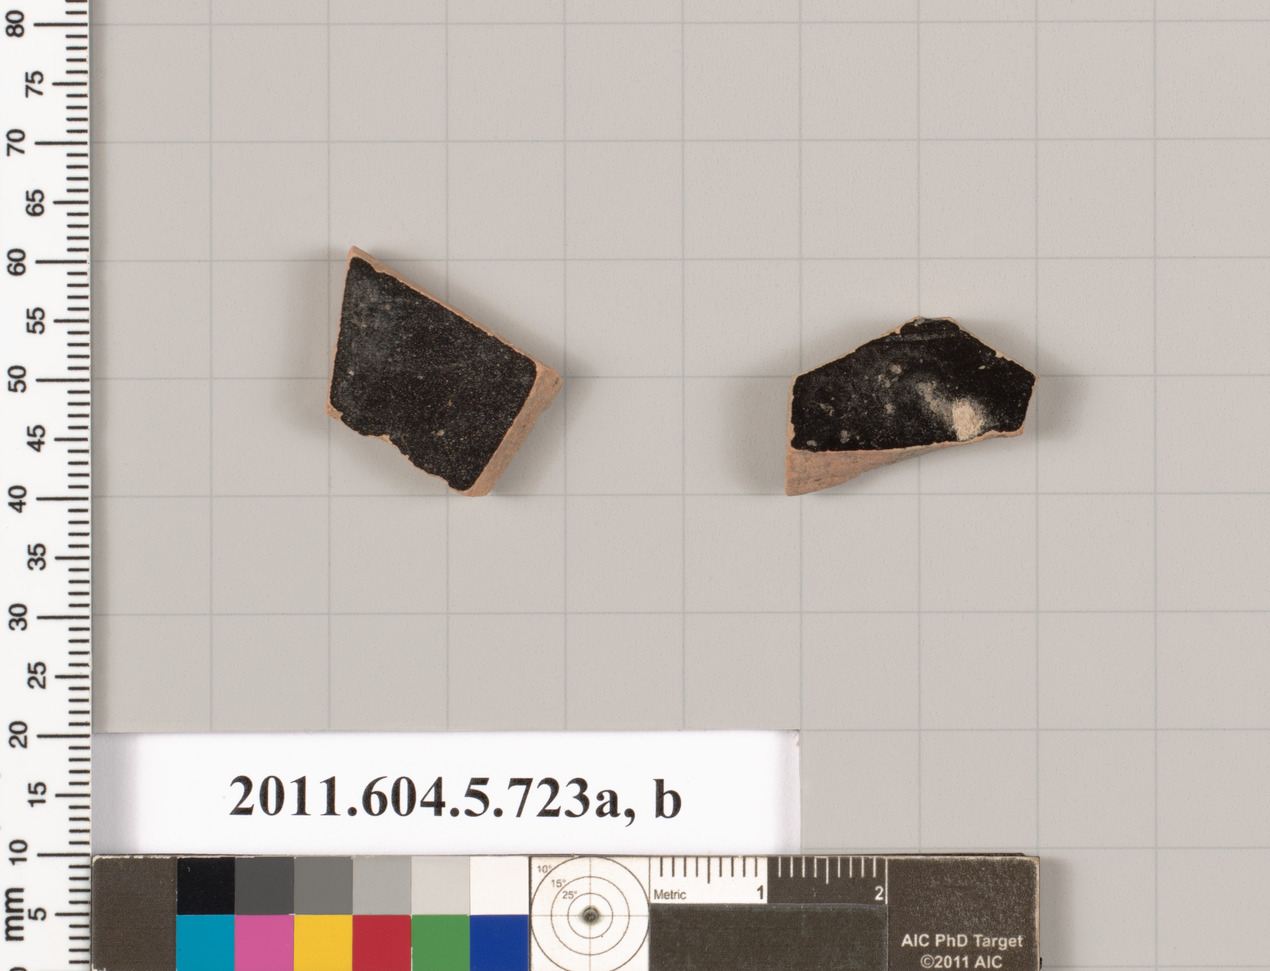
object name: kylix fragment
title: Terracotta fragments of kylikes (drinking cups)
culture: greek, attic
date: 600-401 BCE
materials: terracotta